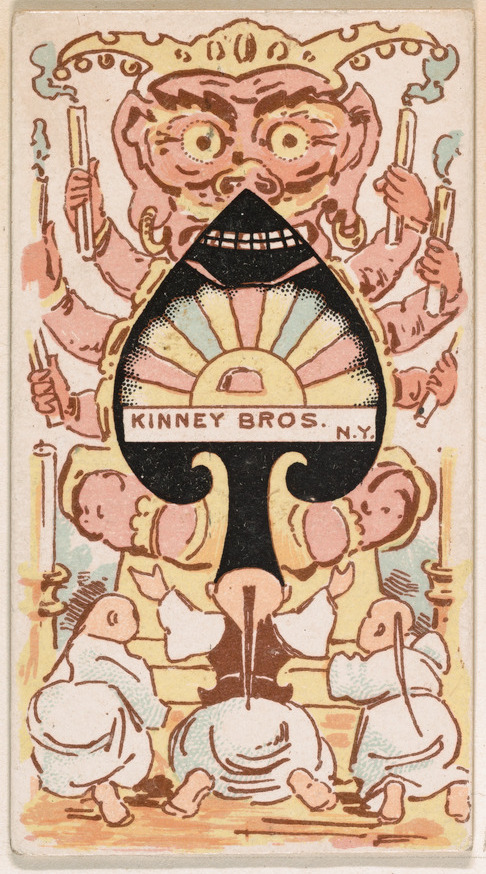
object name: print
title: Ace of Spades, from Harlequin Cards, 2nd Series (N220) issued by Kinney Bros.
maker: kinney brothers tobacco company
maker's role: publisher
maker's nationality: american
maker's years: 1869-2011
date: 1889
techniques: color lithograph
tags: playing cards